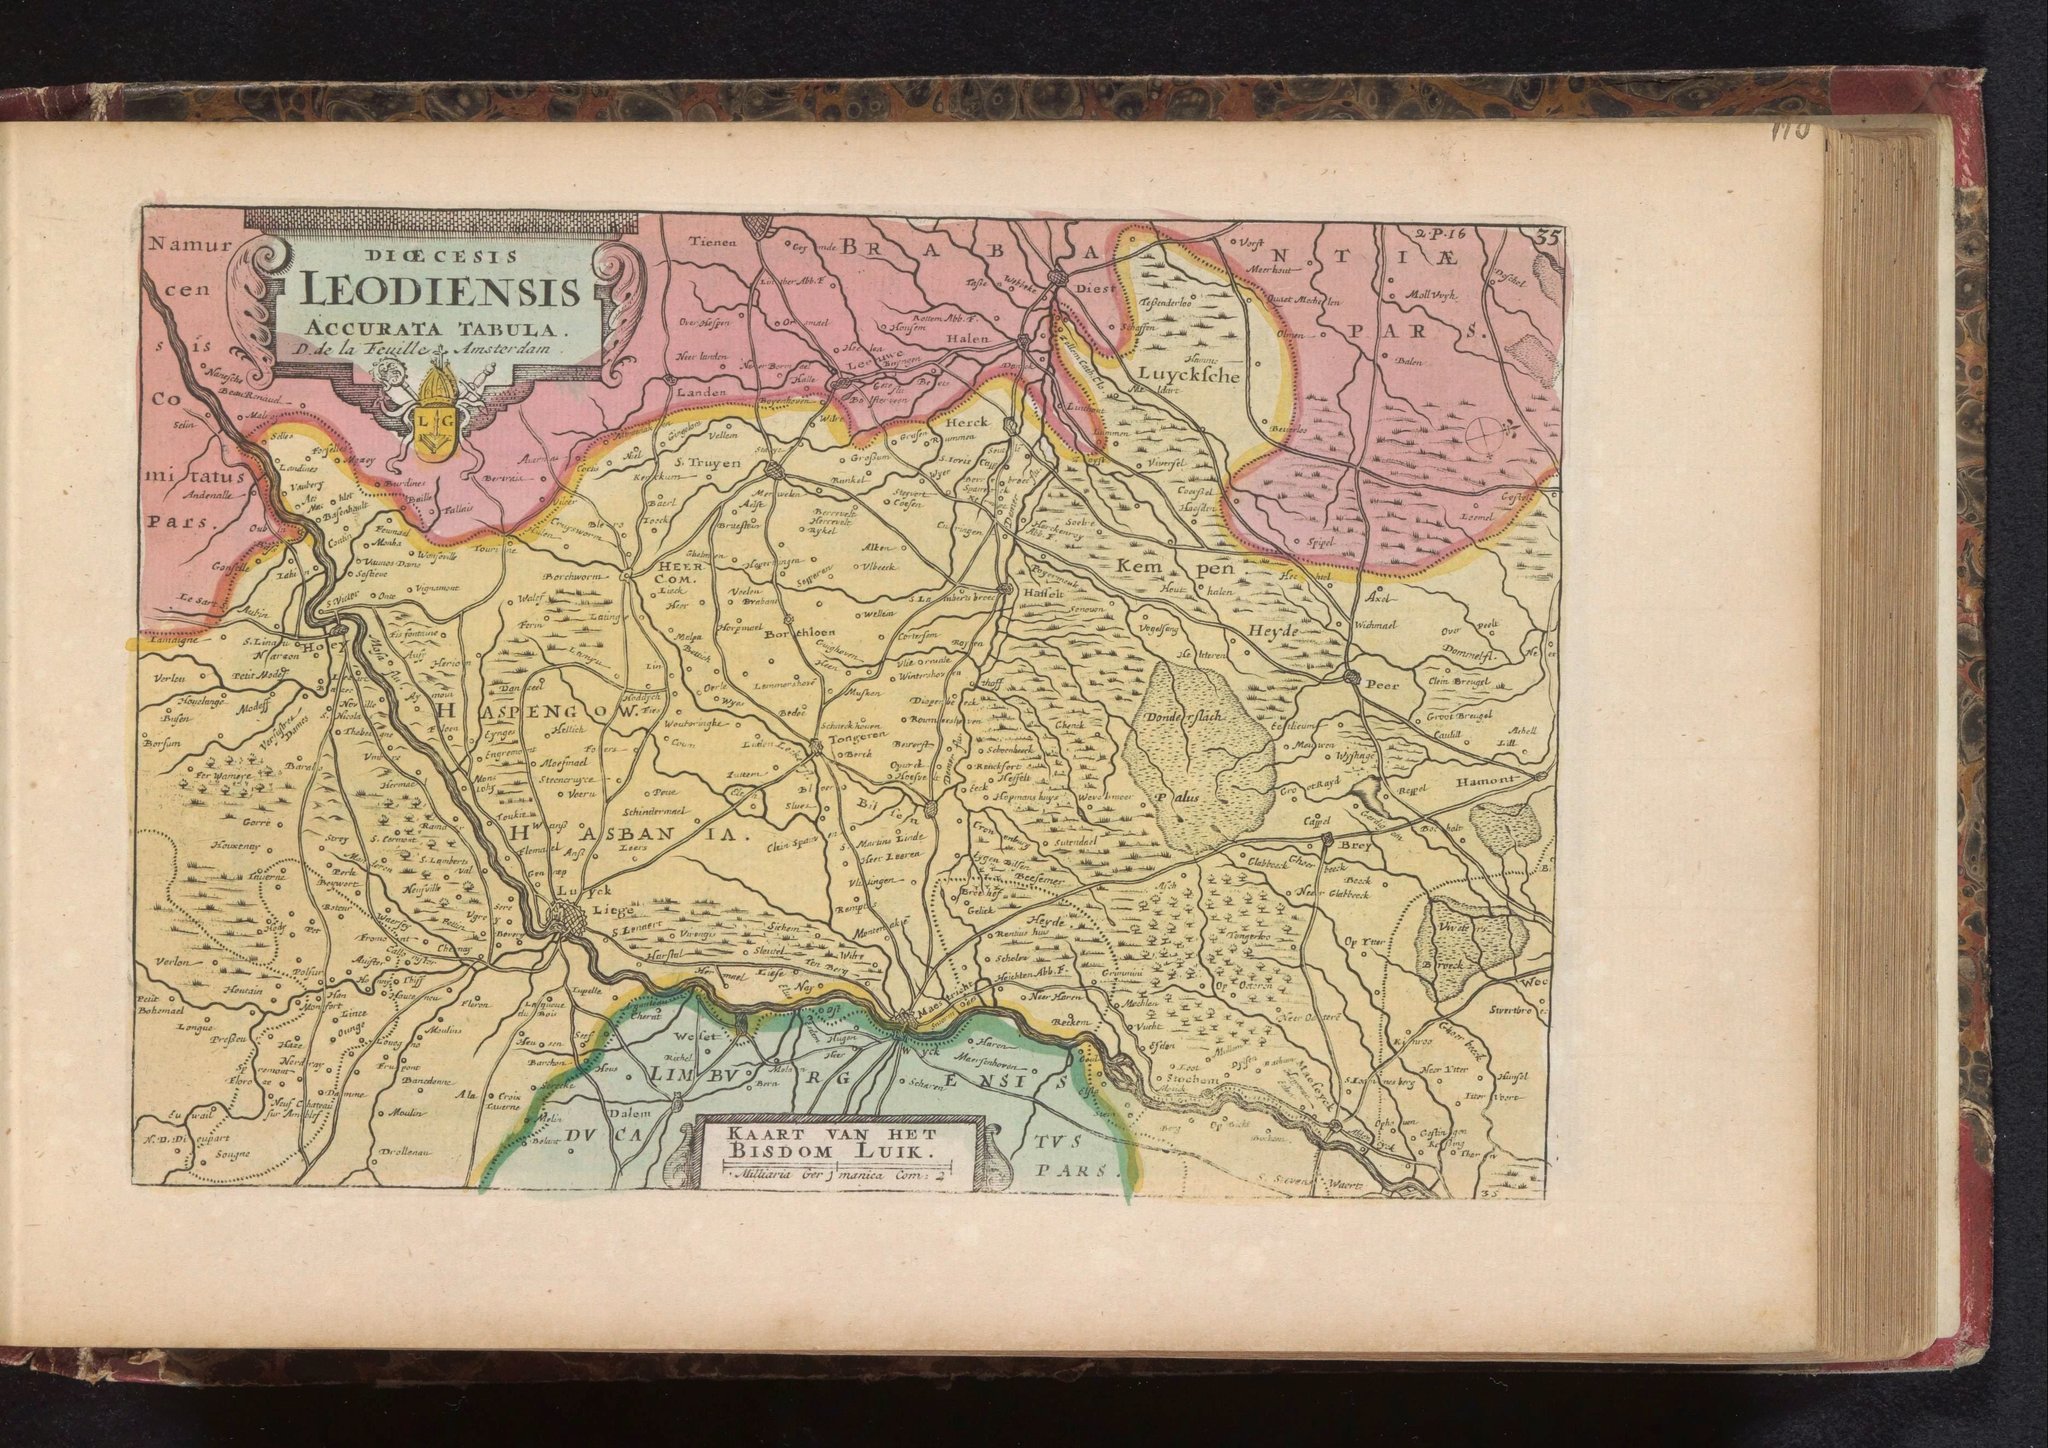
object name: print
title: Kaart van bisdom Luik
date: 1700-1706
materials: paper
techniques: engraving, hand coloring, lacquer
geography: amsterdam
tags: maps of separate countries or regions, prince-bishopric of liège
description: Kaart van het bisdom Luik. Onderdeel van een atlas met 223 kaarten van landen en steden en oorlogstaferelen in Europa in de periode ca. 1690-1735.